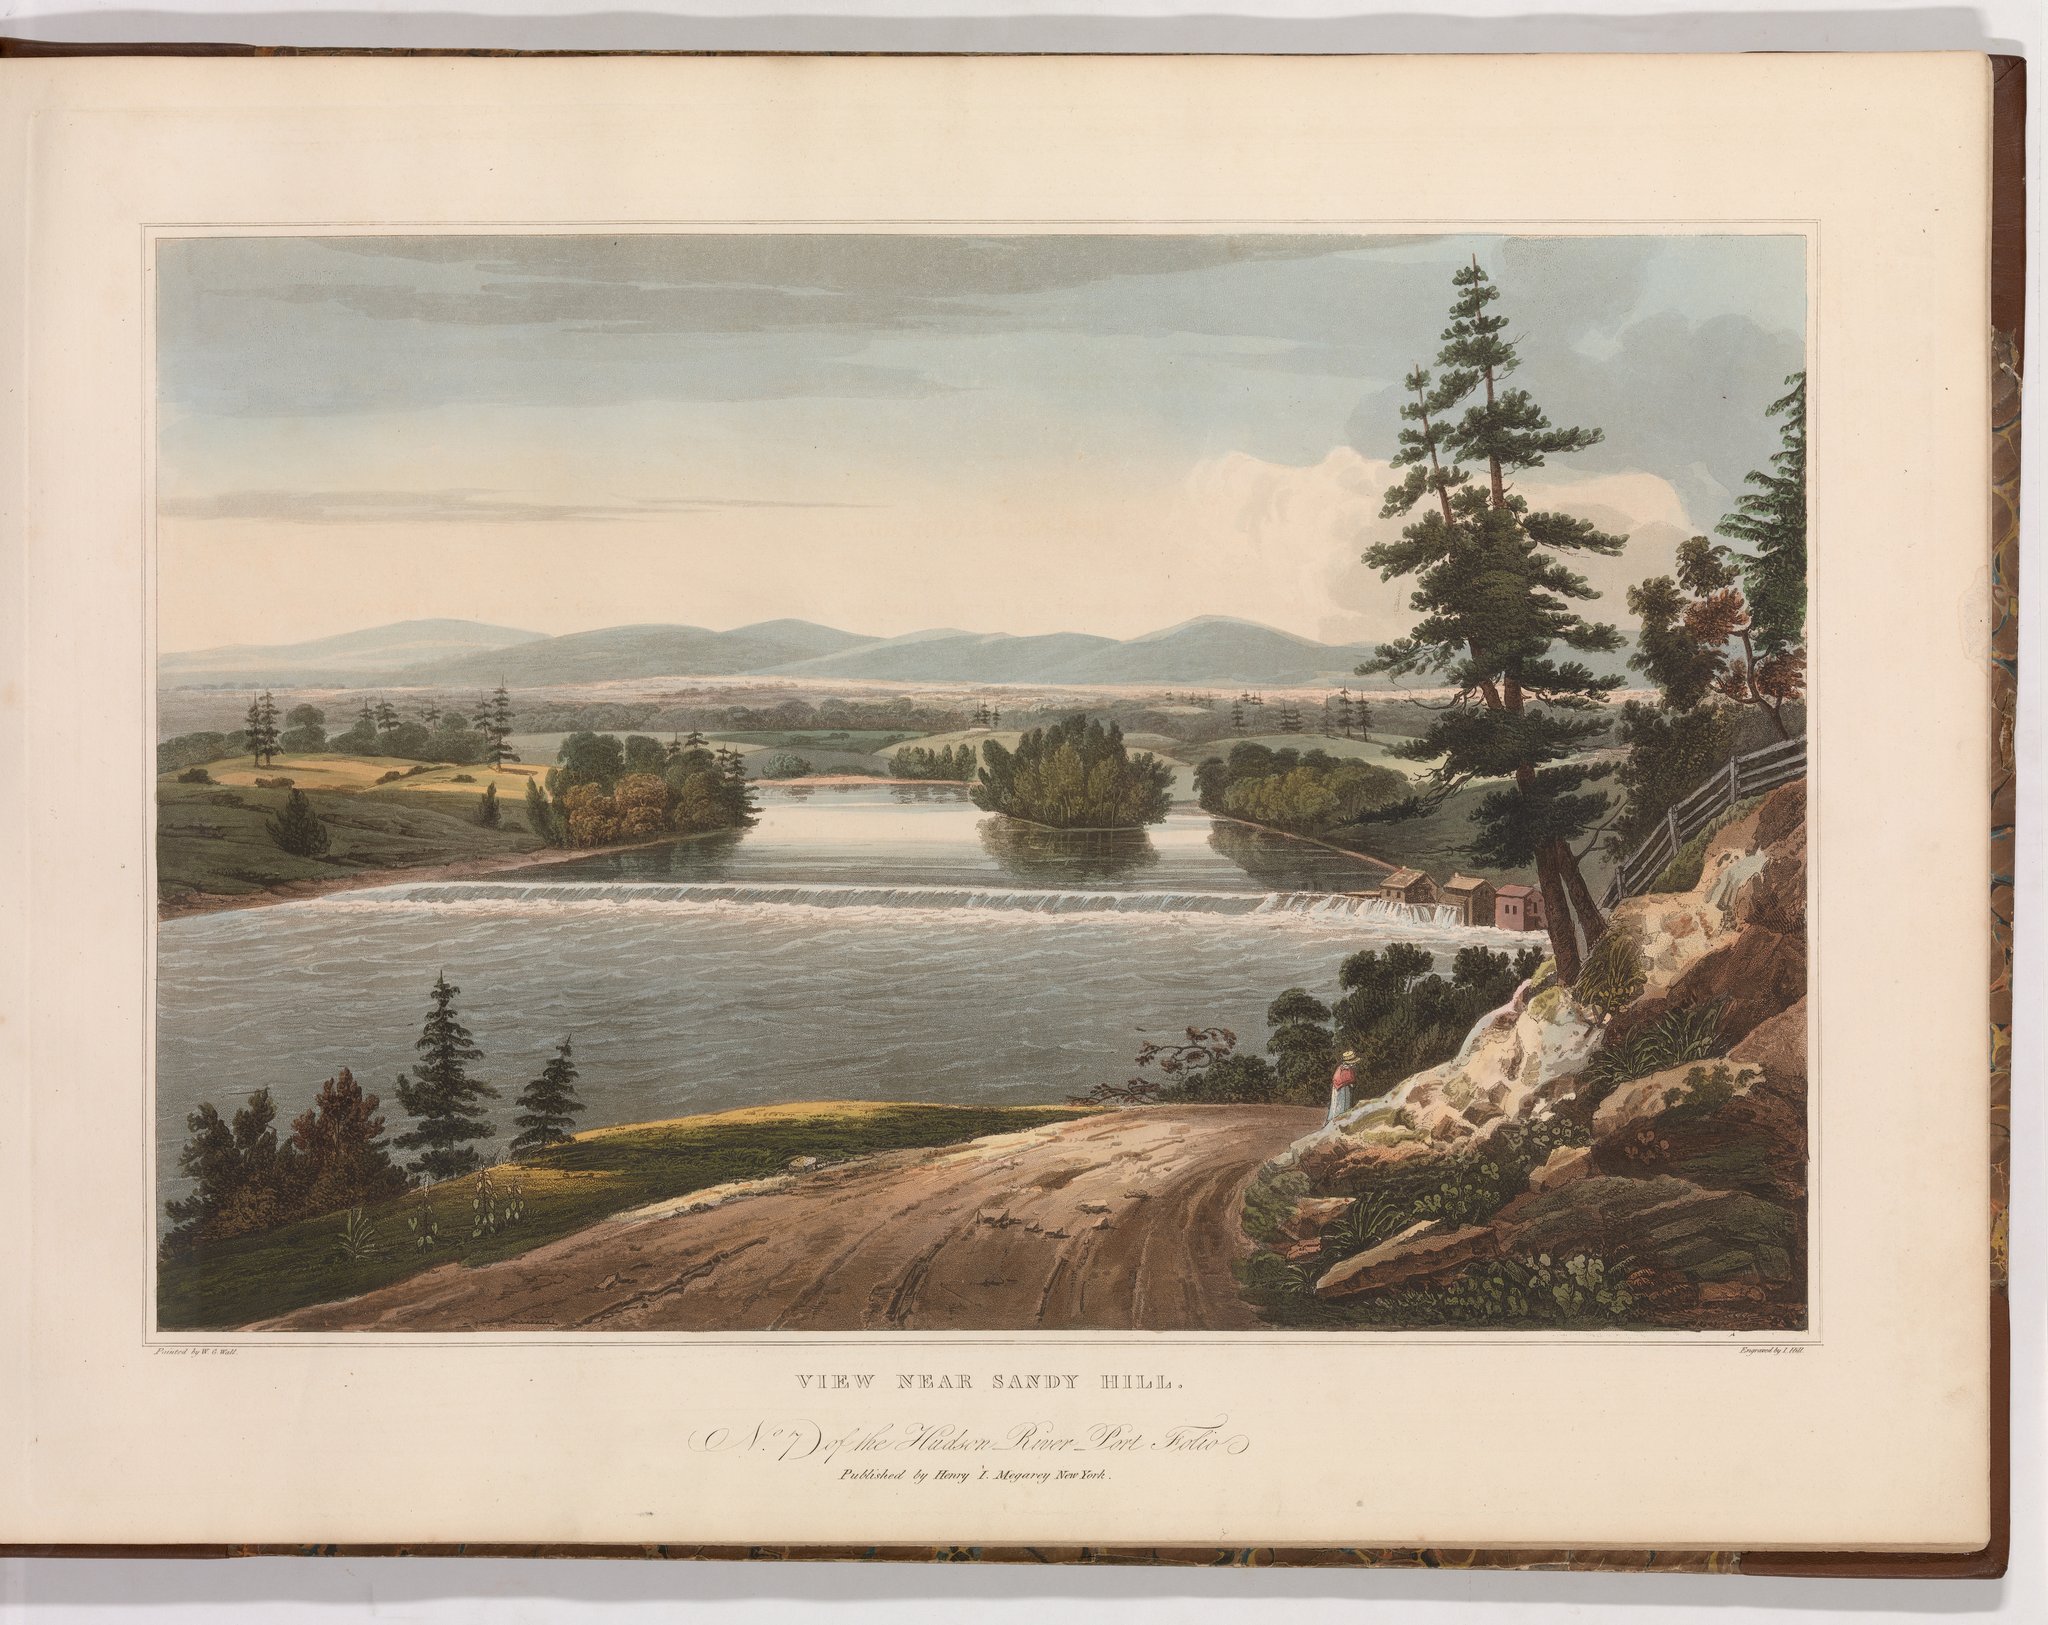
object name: print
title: View Near Sandy Hill (No. 7 of The Hudson River Portfolio)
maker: john hill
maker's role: etcher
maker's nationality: american, born england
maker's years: 1770-1850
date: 1822-1823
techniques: aquatint, hand coloring, printing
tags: rivers,hills,landscapes